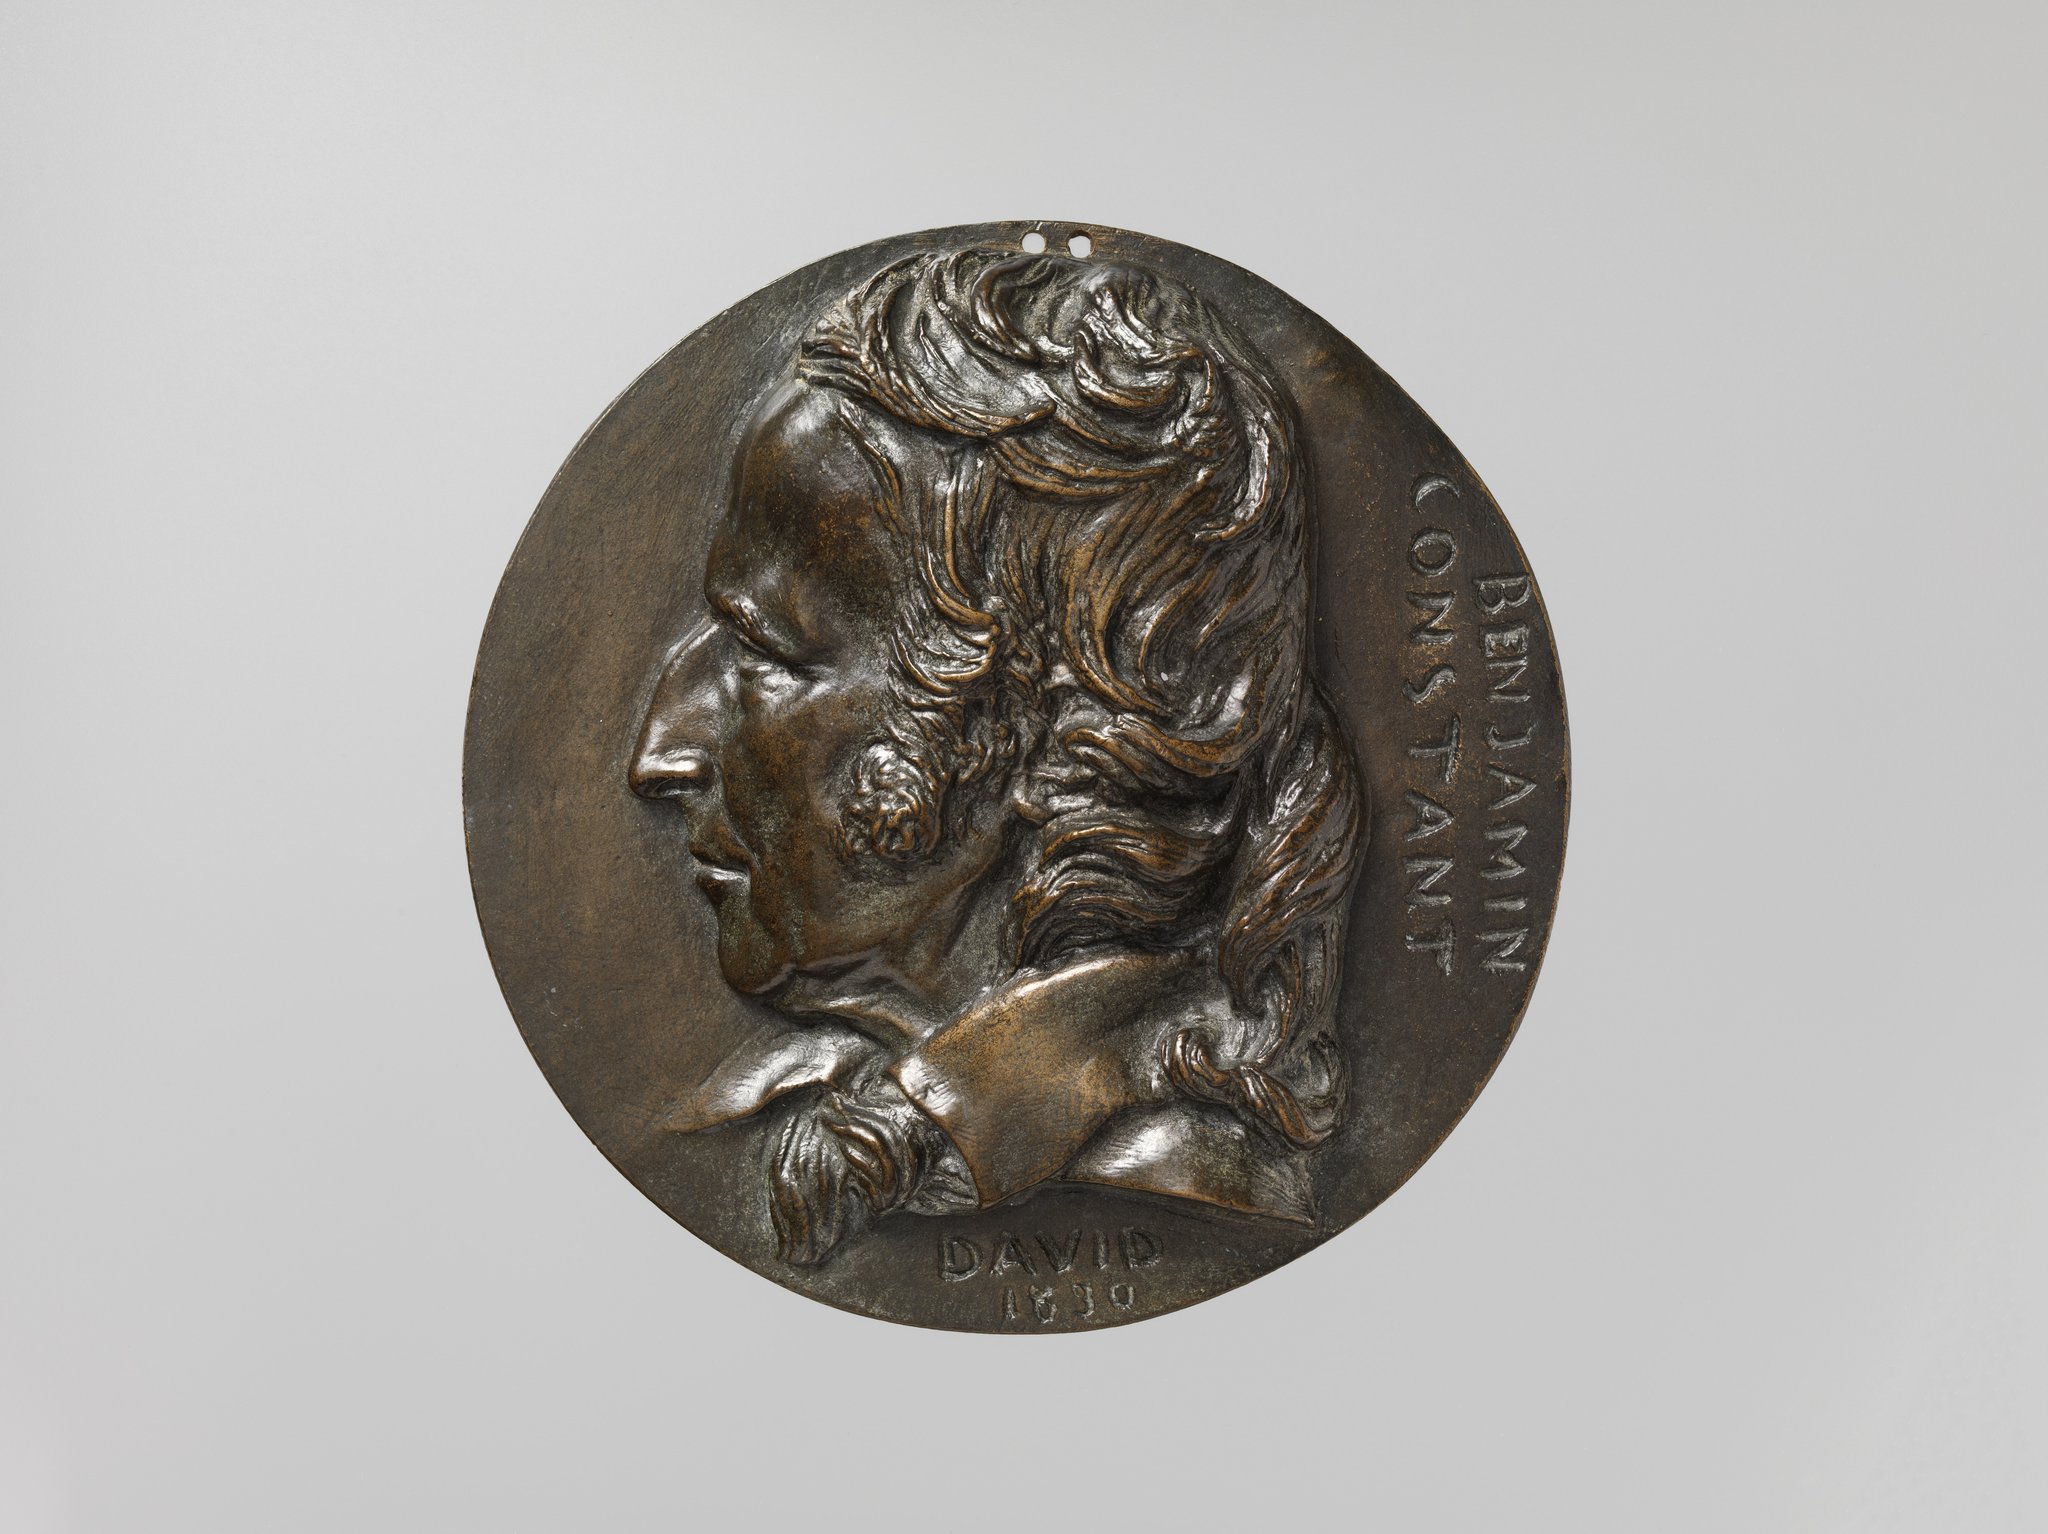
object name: medallion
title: Henri-Benjamin Constant de Rebecque (1767–1830)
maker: pierre jean david d'angers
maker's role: maker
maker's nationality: french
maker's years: 1788-1856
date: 1830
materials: bronze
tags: men,profiles